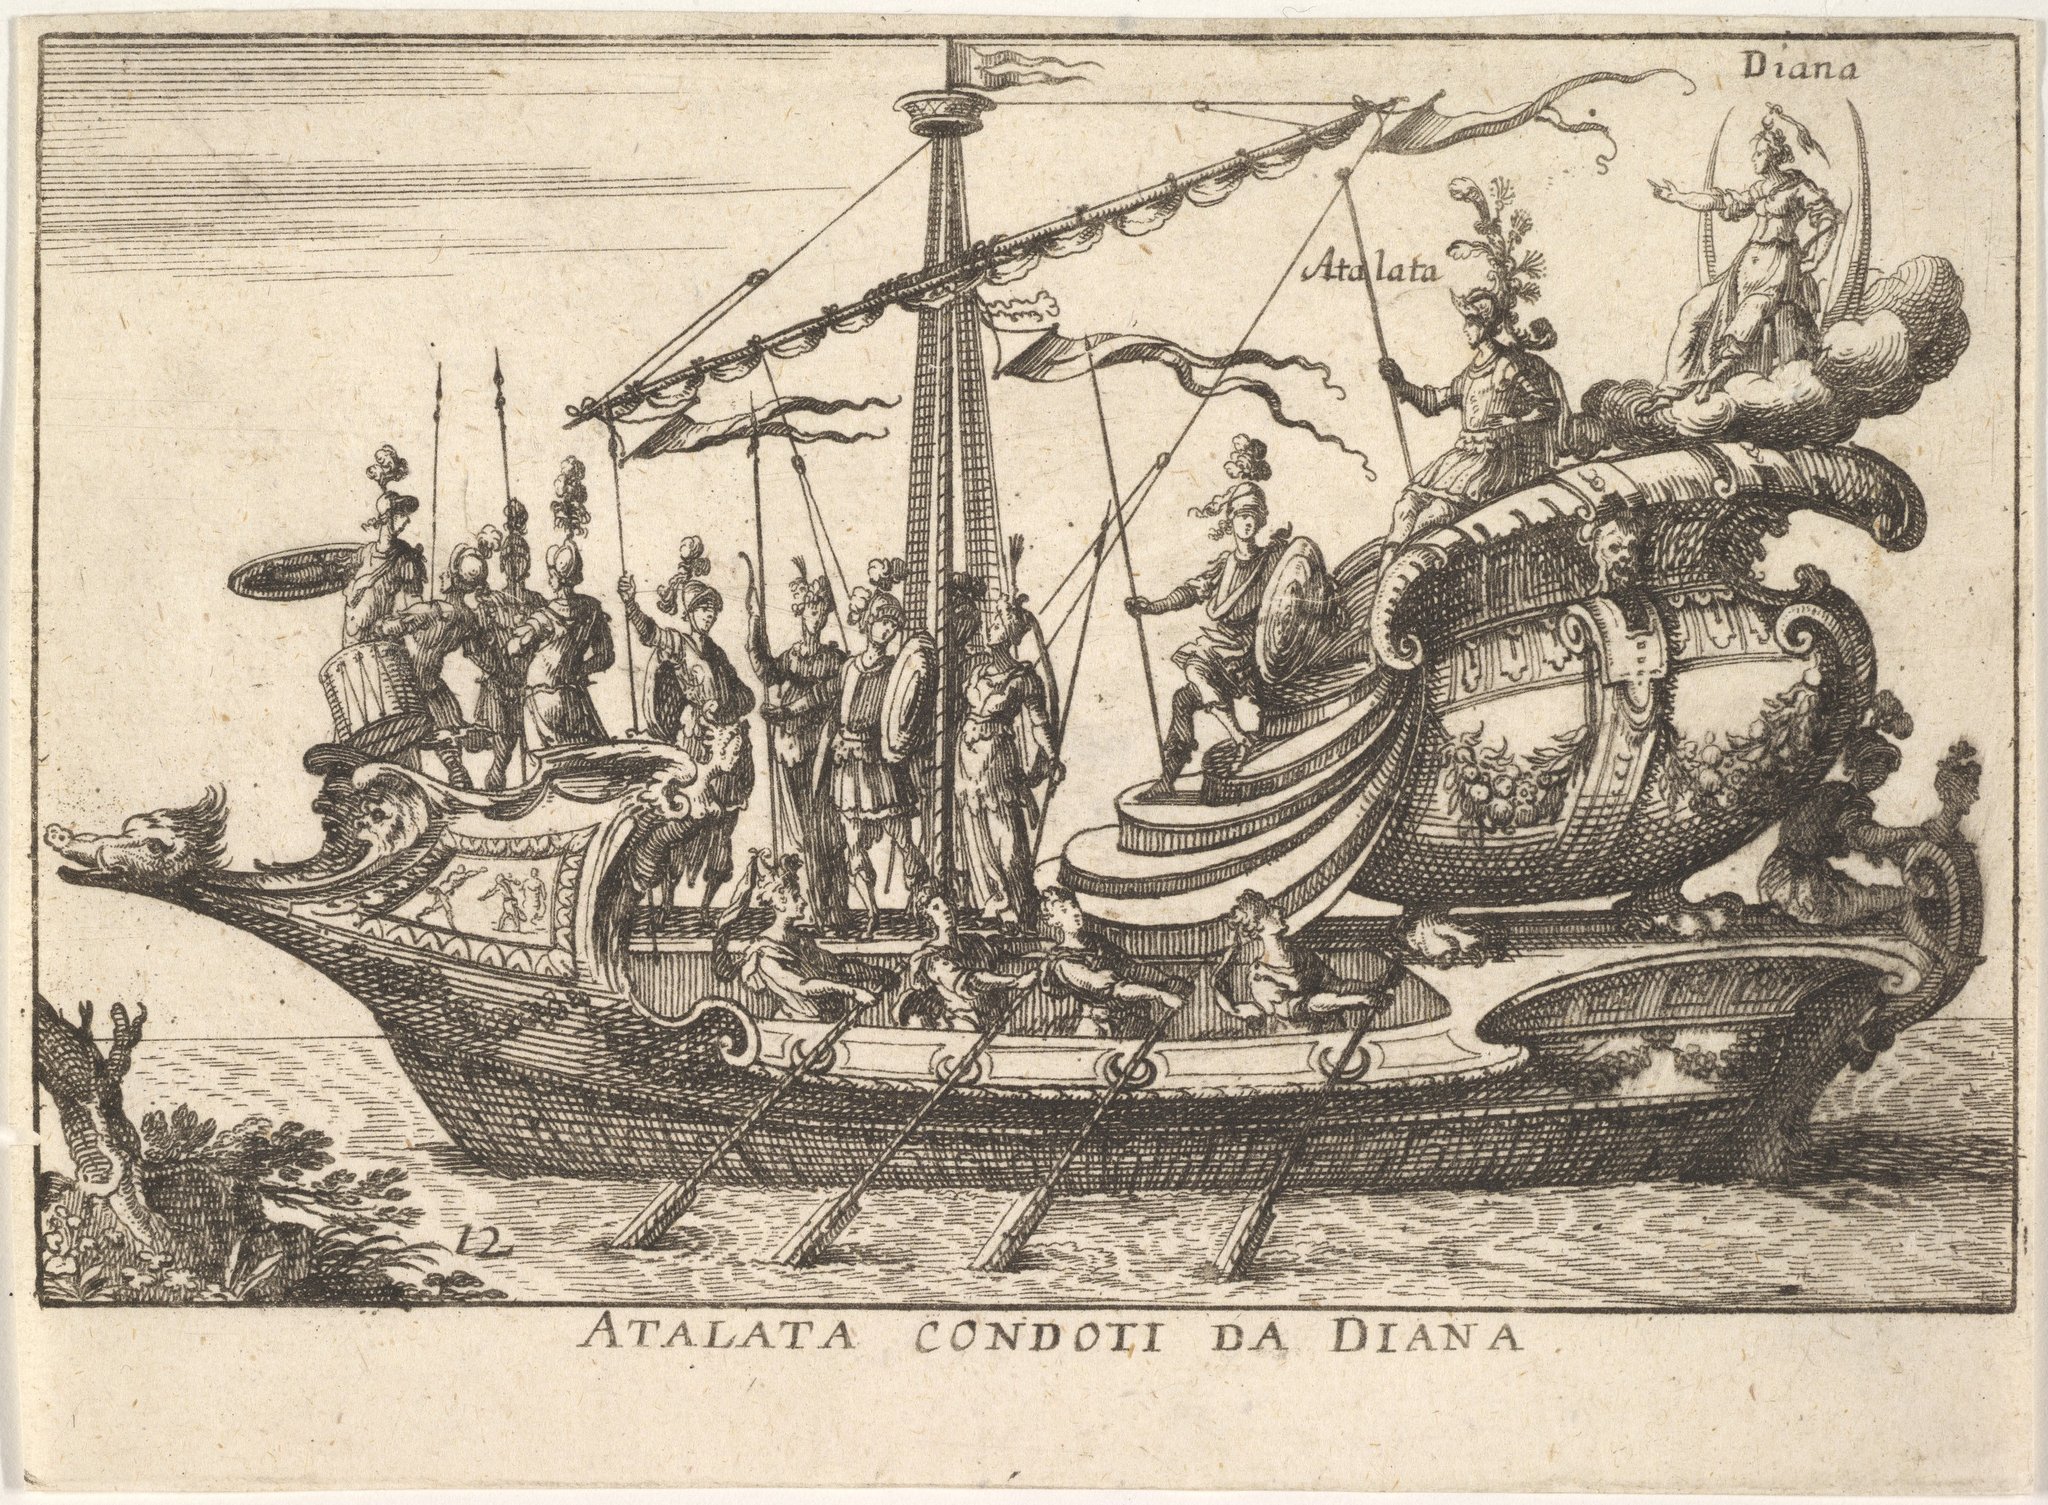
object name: print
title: Plate 12: Atalanta led by Diana (Atalata condoti da Diana), from "The magnificent pageant on the river Arno in Florence for the marriage of the Grand Duke" (Le Magnifique carousel fait sur le fleuve de l'Arne a Florence, pour le mariage du Grand Duc)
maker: Anonymous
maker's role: artist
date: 1664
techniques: etching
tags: soldiers,diana,rivers,ships